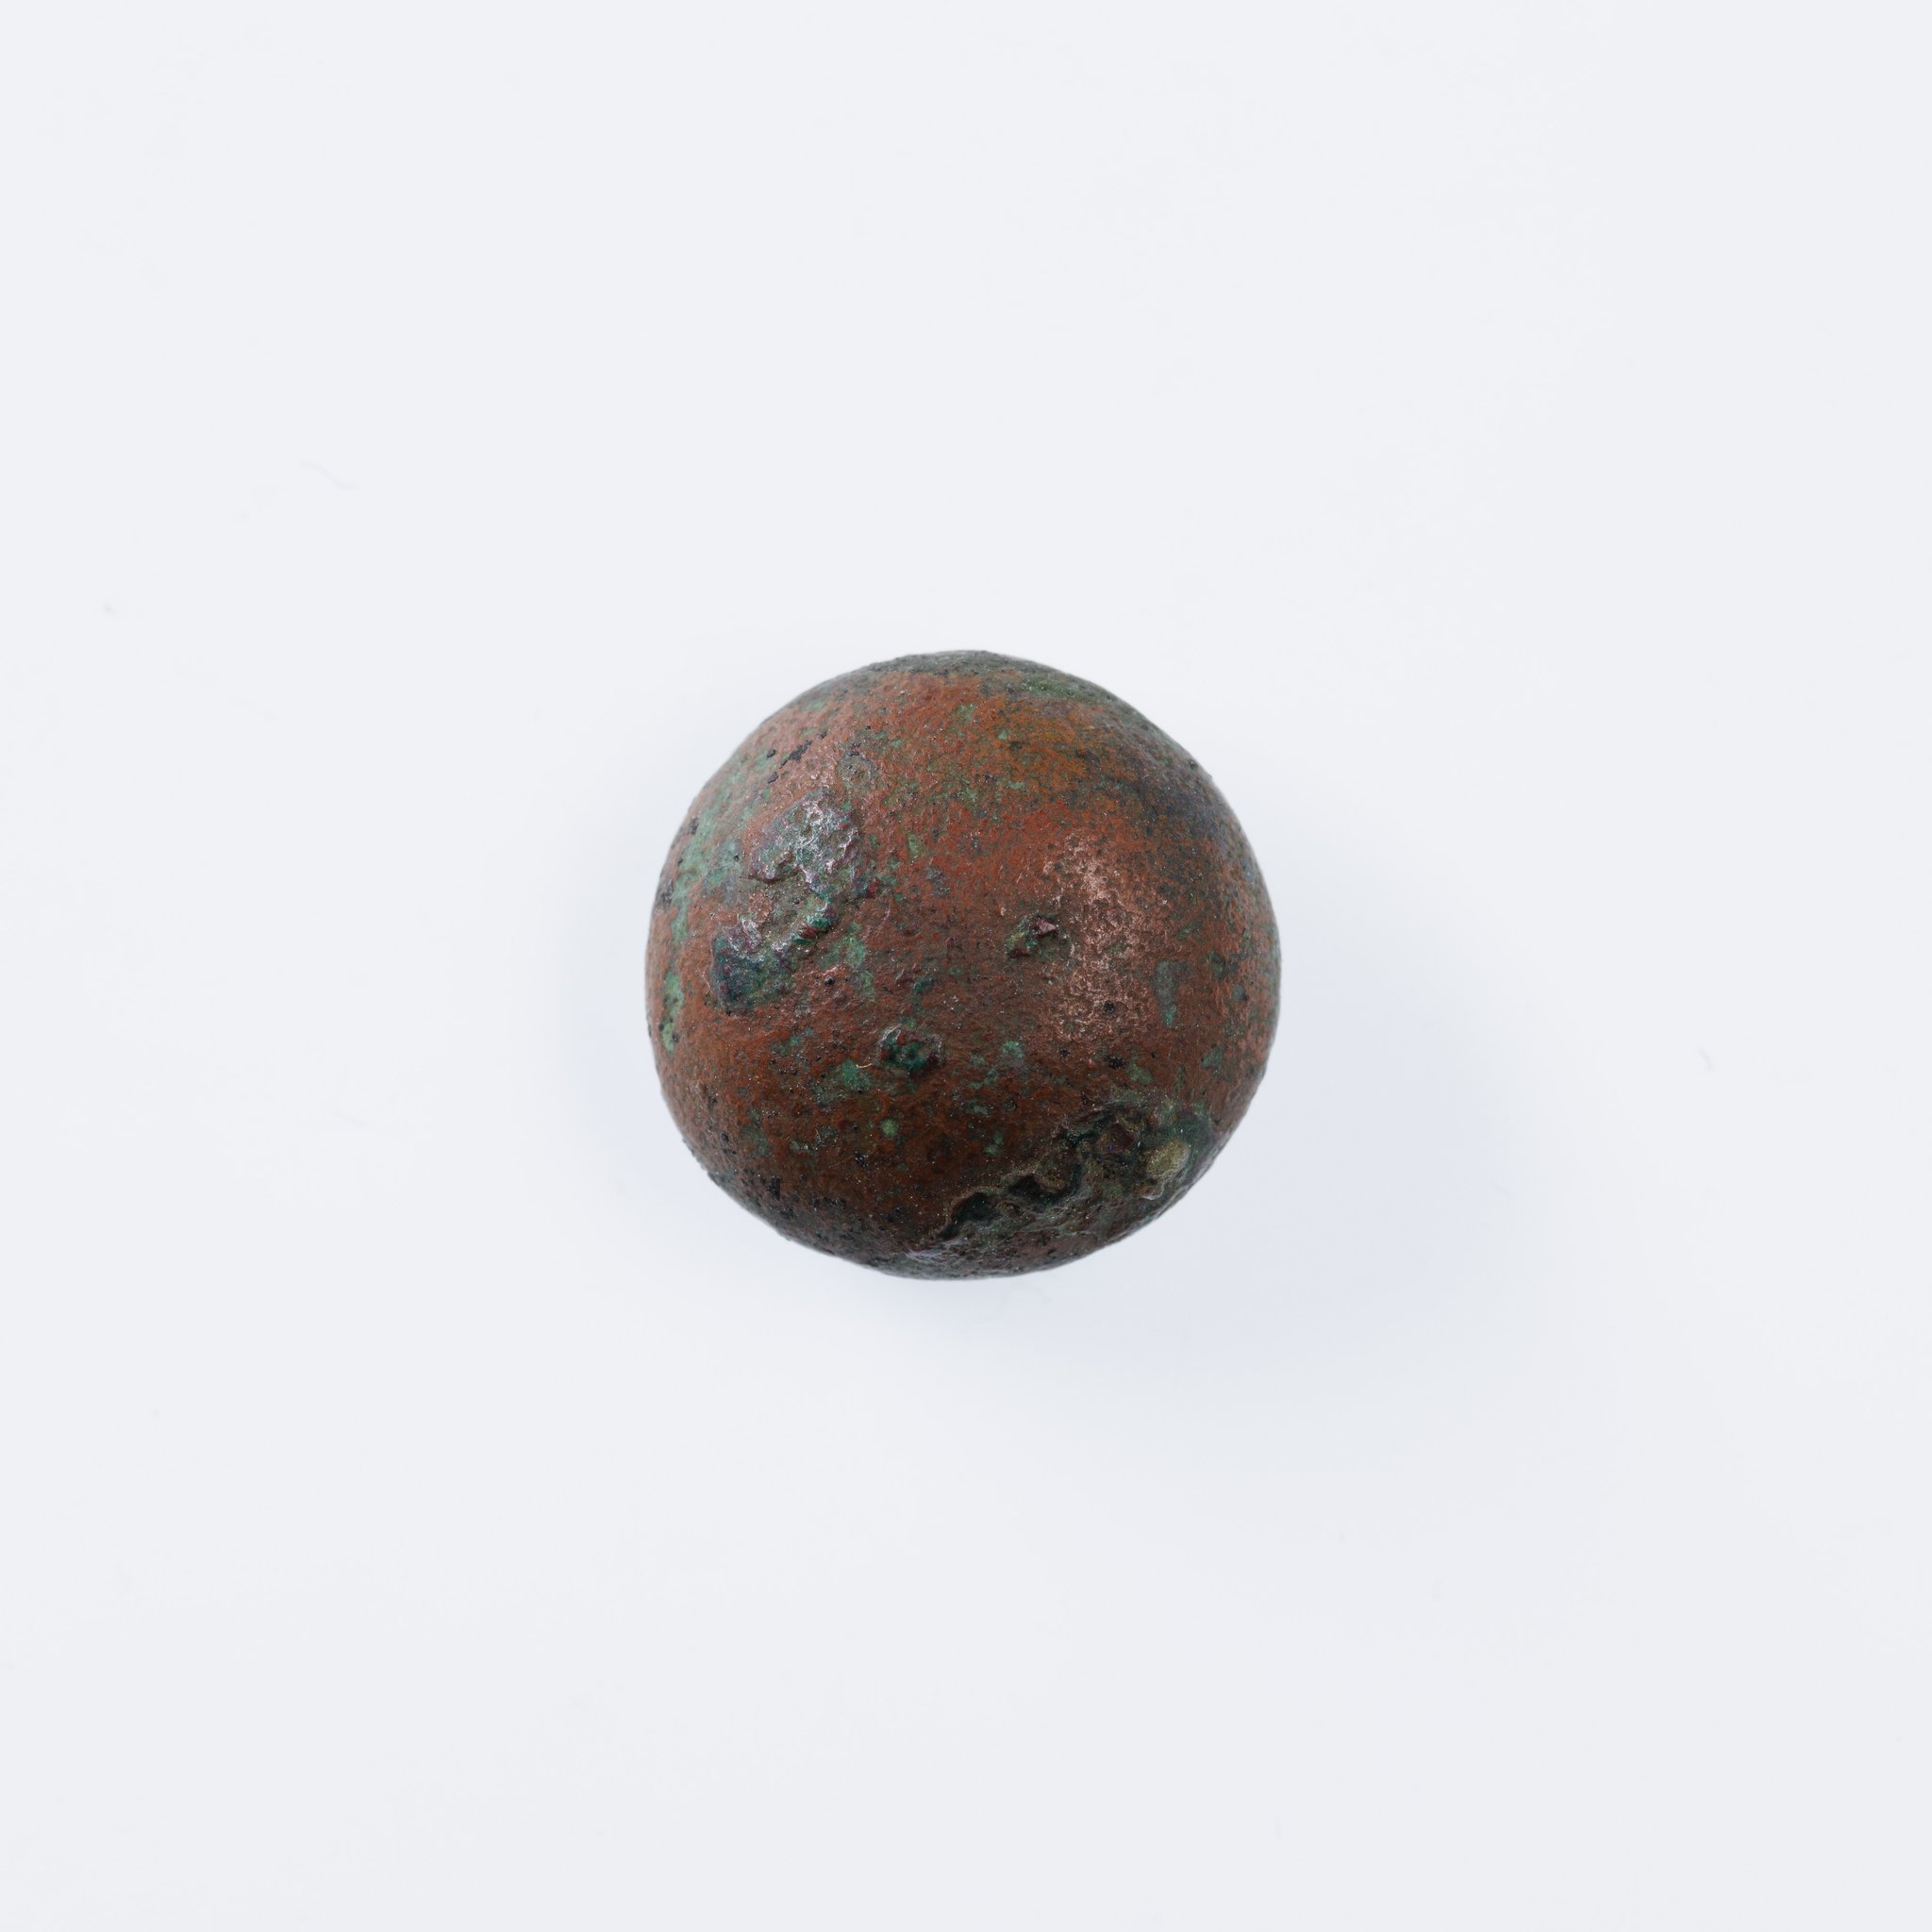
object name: weight, 1 4 kedet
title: Weight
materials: copper alloy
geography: egypt